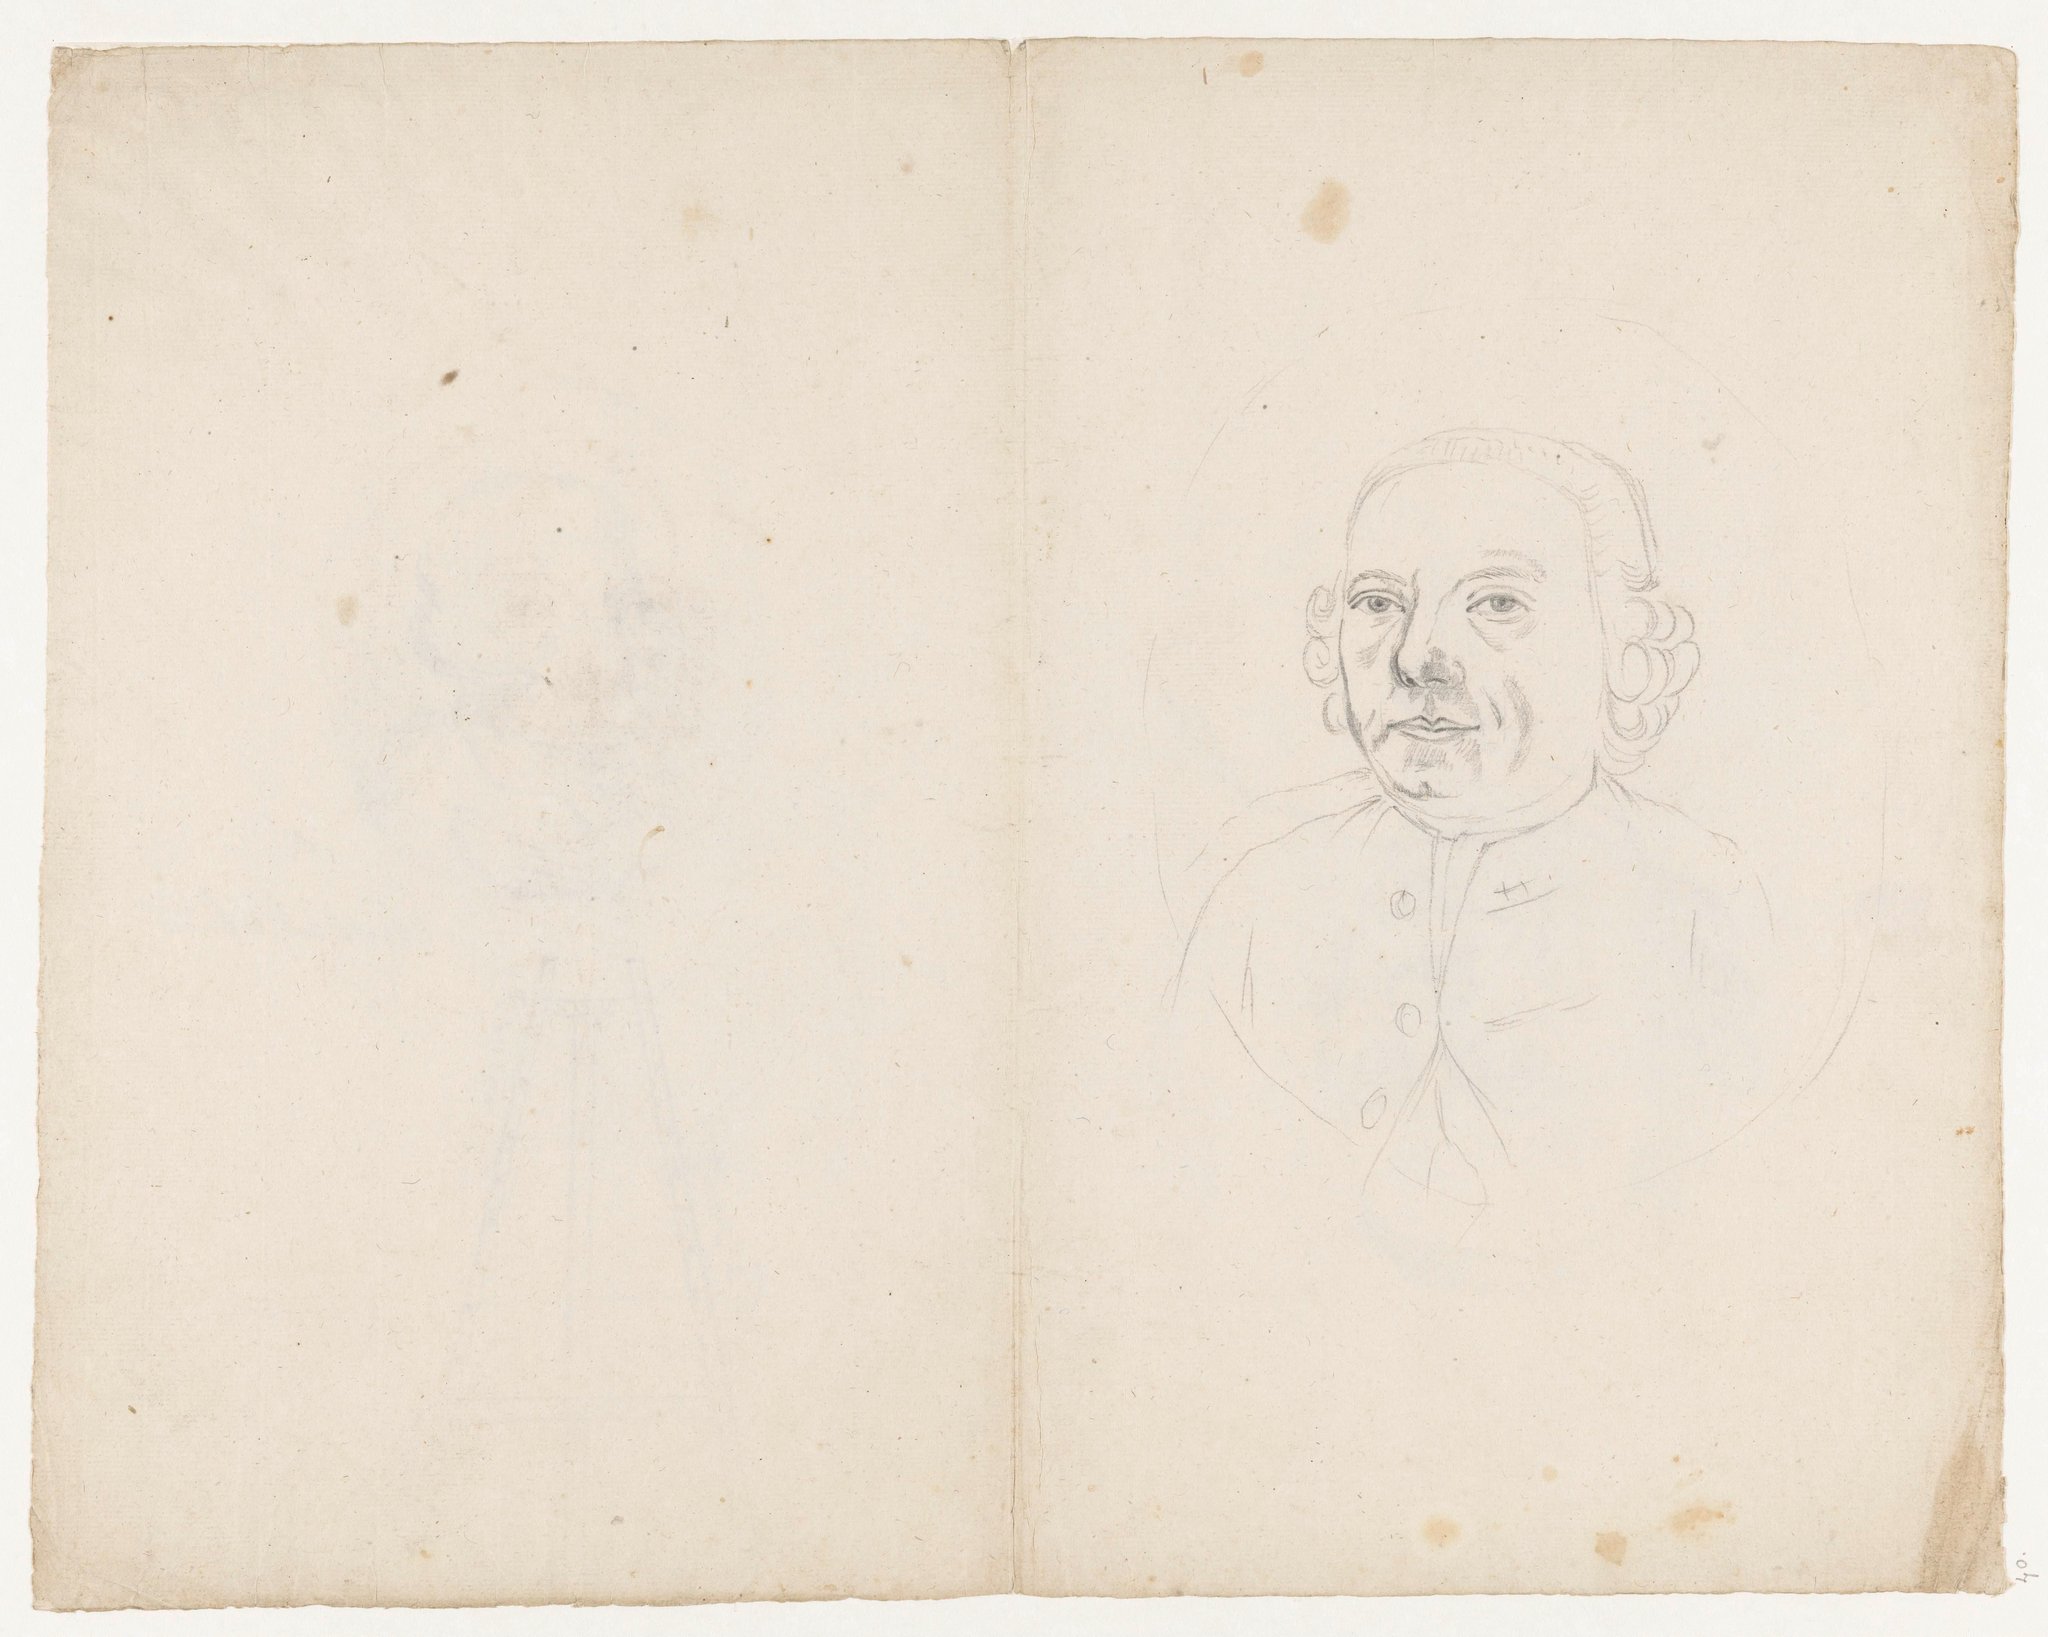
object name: drawing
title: Portret van Per Johan Wimermark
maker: jan brandes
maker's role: draughtsman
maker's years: 1743-1808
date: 1788-1806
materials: paper, pencil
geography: skälsebo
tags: historical persons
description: Schets met een portret van een man, wellicht schoonvader Wimermark. Op de achterkant nog een versie van dit portret, een medaillonportret en een schildersezel 'chevalet'. Met opschrift.